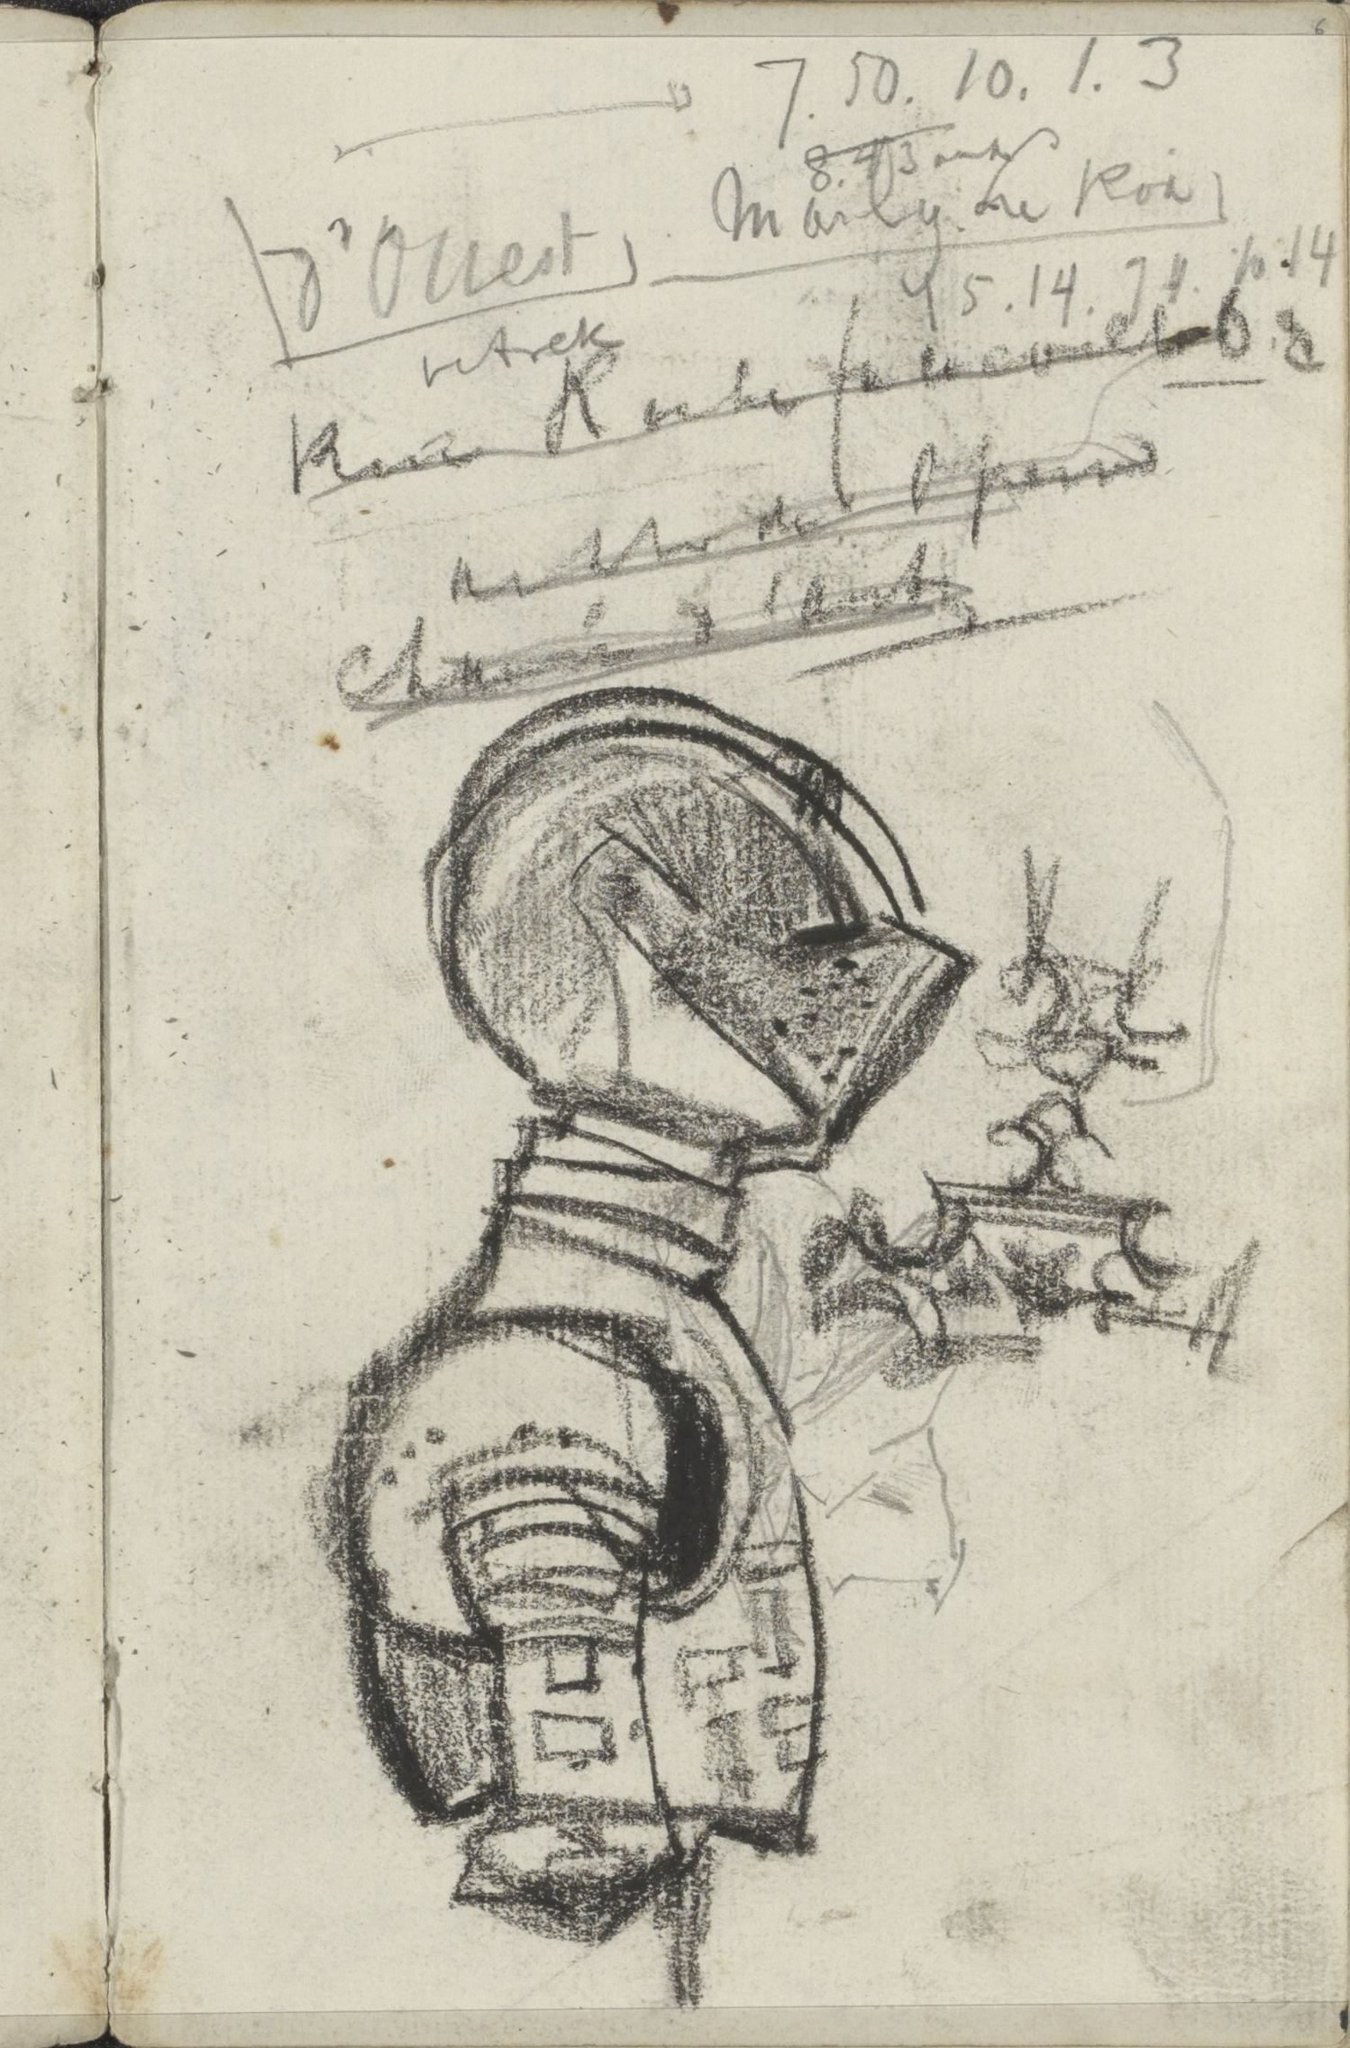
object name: sketchbook leaf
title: Harnas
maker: george hendrik breitner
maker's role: draughtsman, painter, print maker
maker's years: 1857-1923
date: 1884-1886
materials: chalk, paper, pencil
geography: paris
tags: armour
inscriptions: annotation: ‘7. 50. 10. 1. 3/ D'Ouest, Marly le Roi,/ [...]’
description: Pagina 6 uit een schetsboek met 25 bladen.